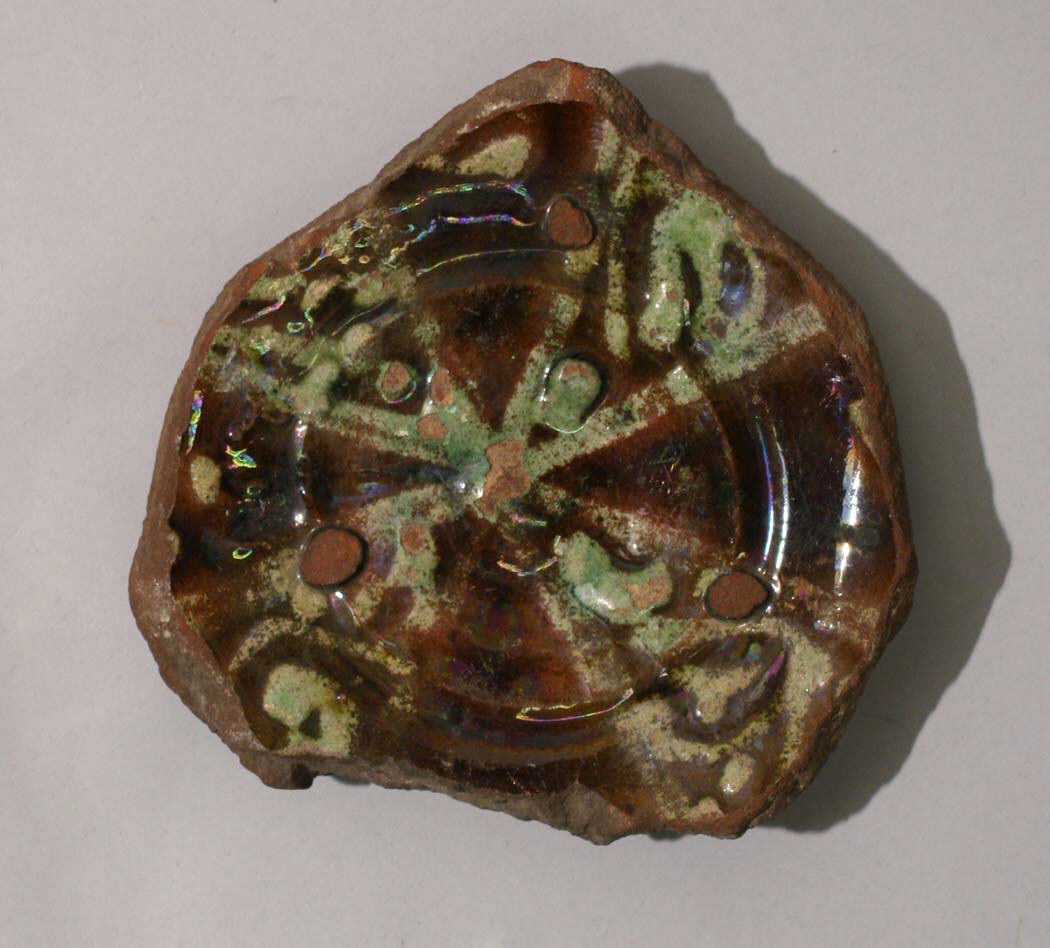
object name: fragment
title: Fragment of a Bowl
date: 1301-1500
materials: earthenware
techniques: glazing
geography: egypt